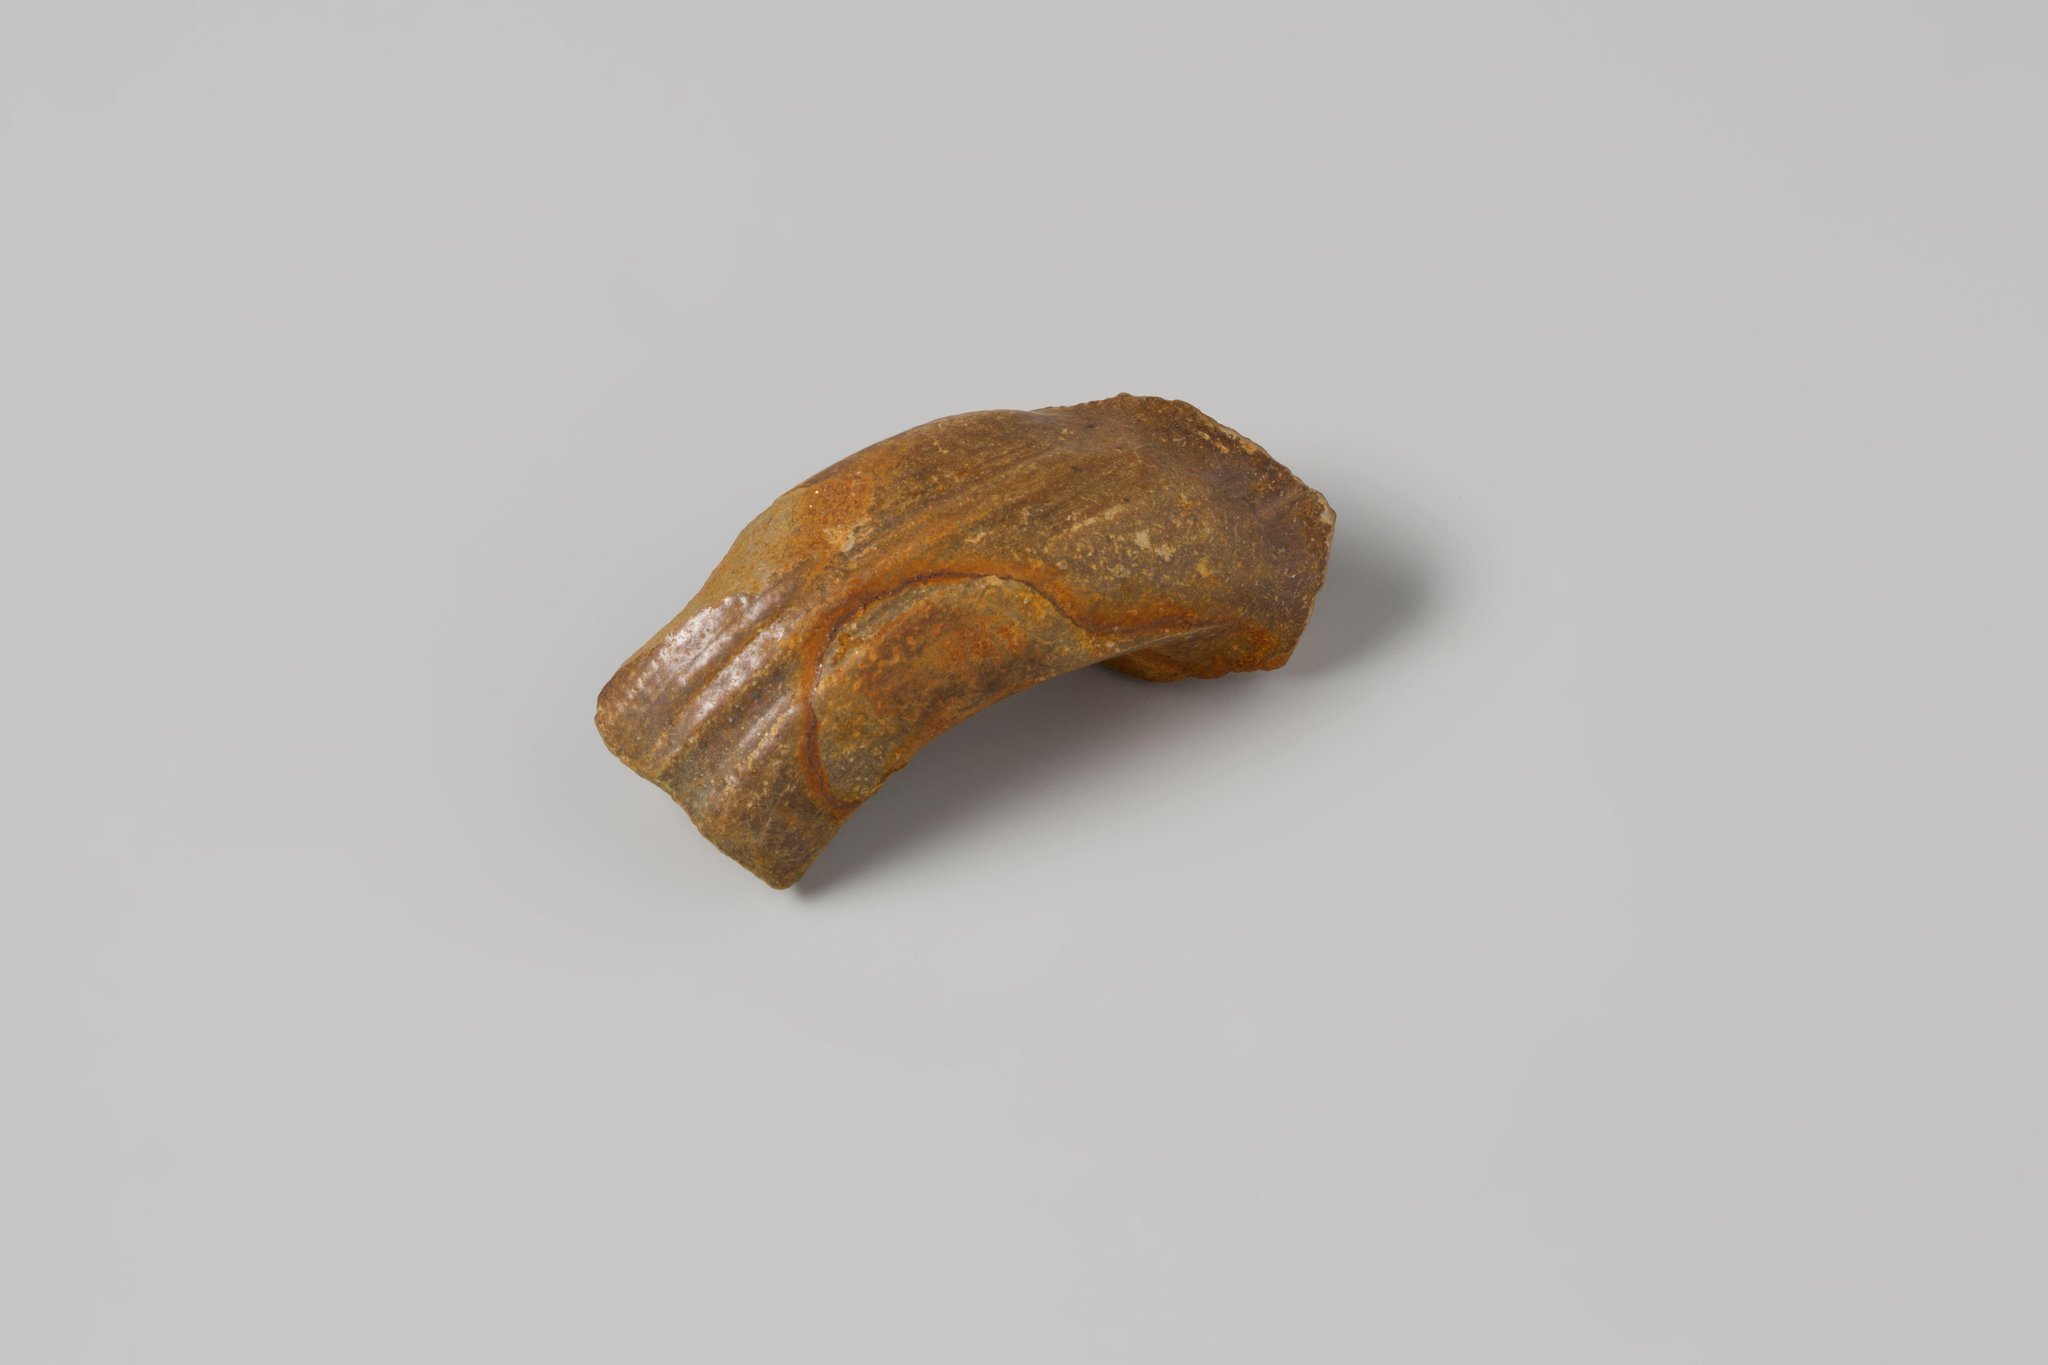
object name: storage jar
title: Oor van een voorraadpot uit het wrak van de Oost-Indiëvaarder Hollandia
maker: Anonymous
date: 1700-1743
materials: stoneware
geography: cologne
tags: verenigde oostindische compagnie, hollandia (schip), annet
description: Stoneware, Rhenish, Langerwehe-ware, storage-jar; fragm of handle, reeded exterior, lens-shaped in section.